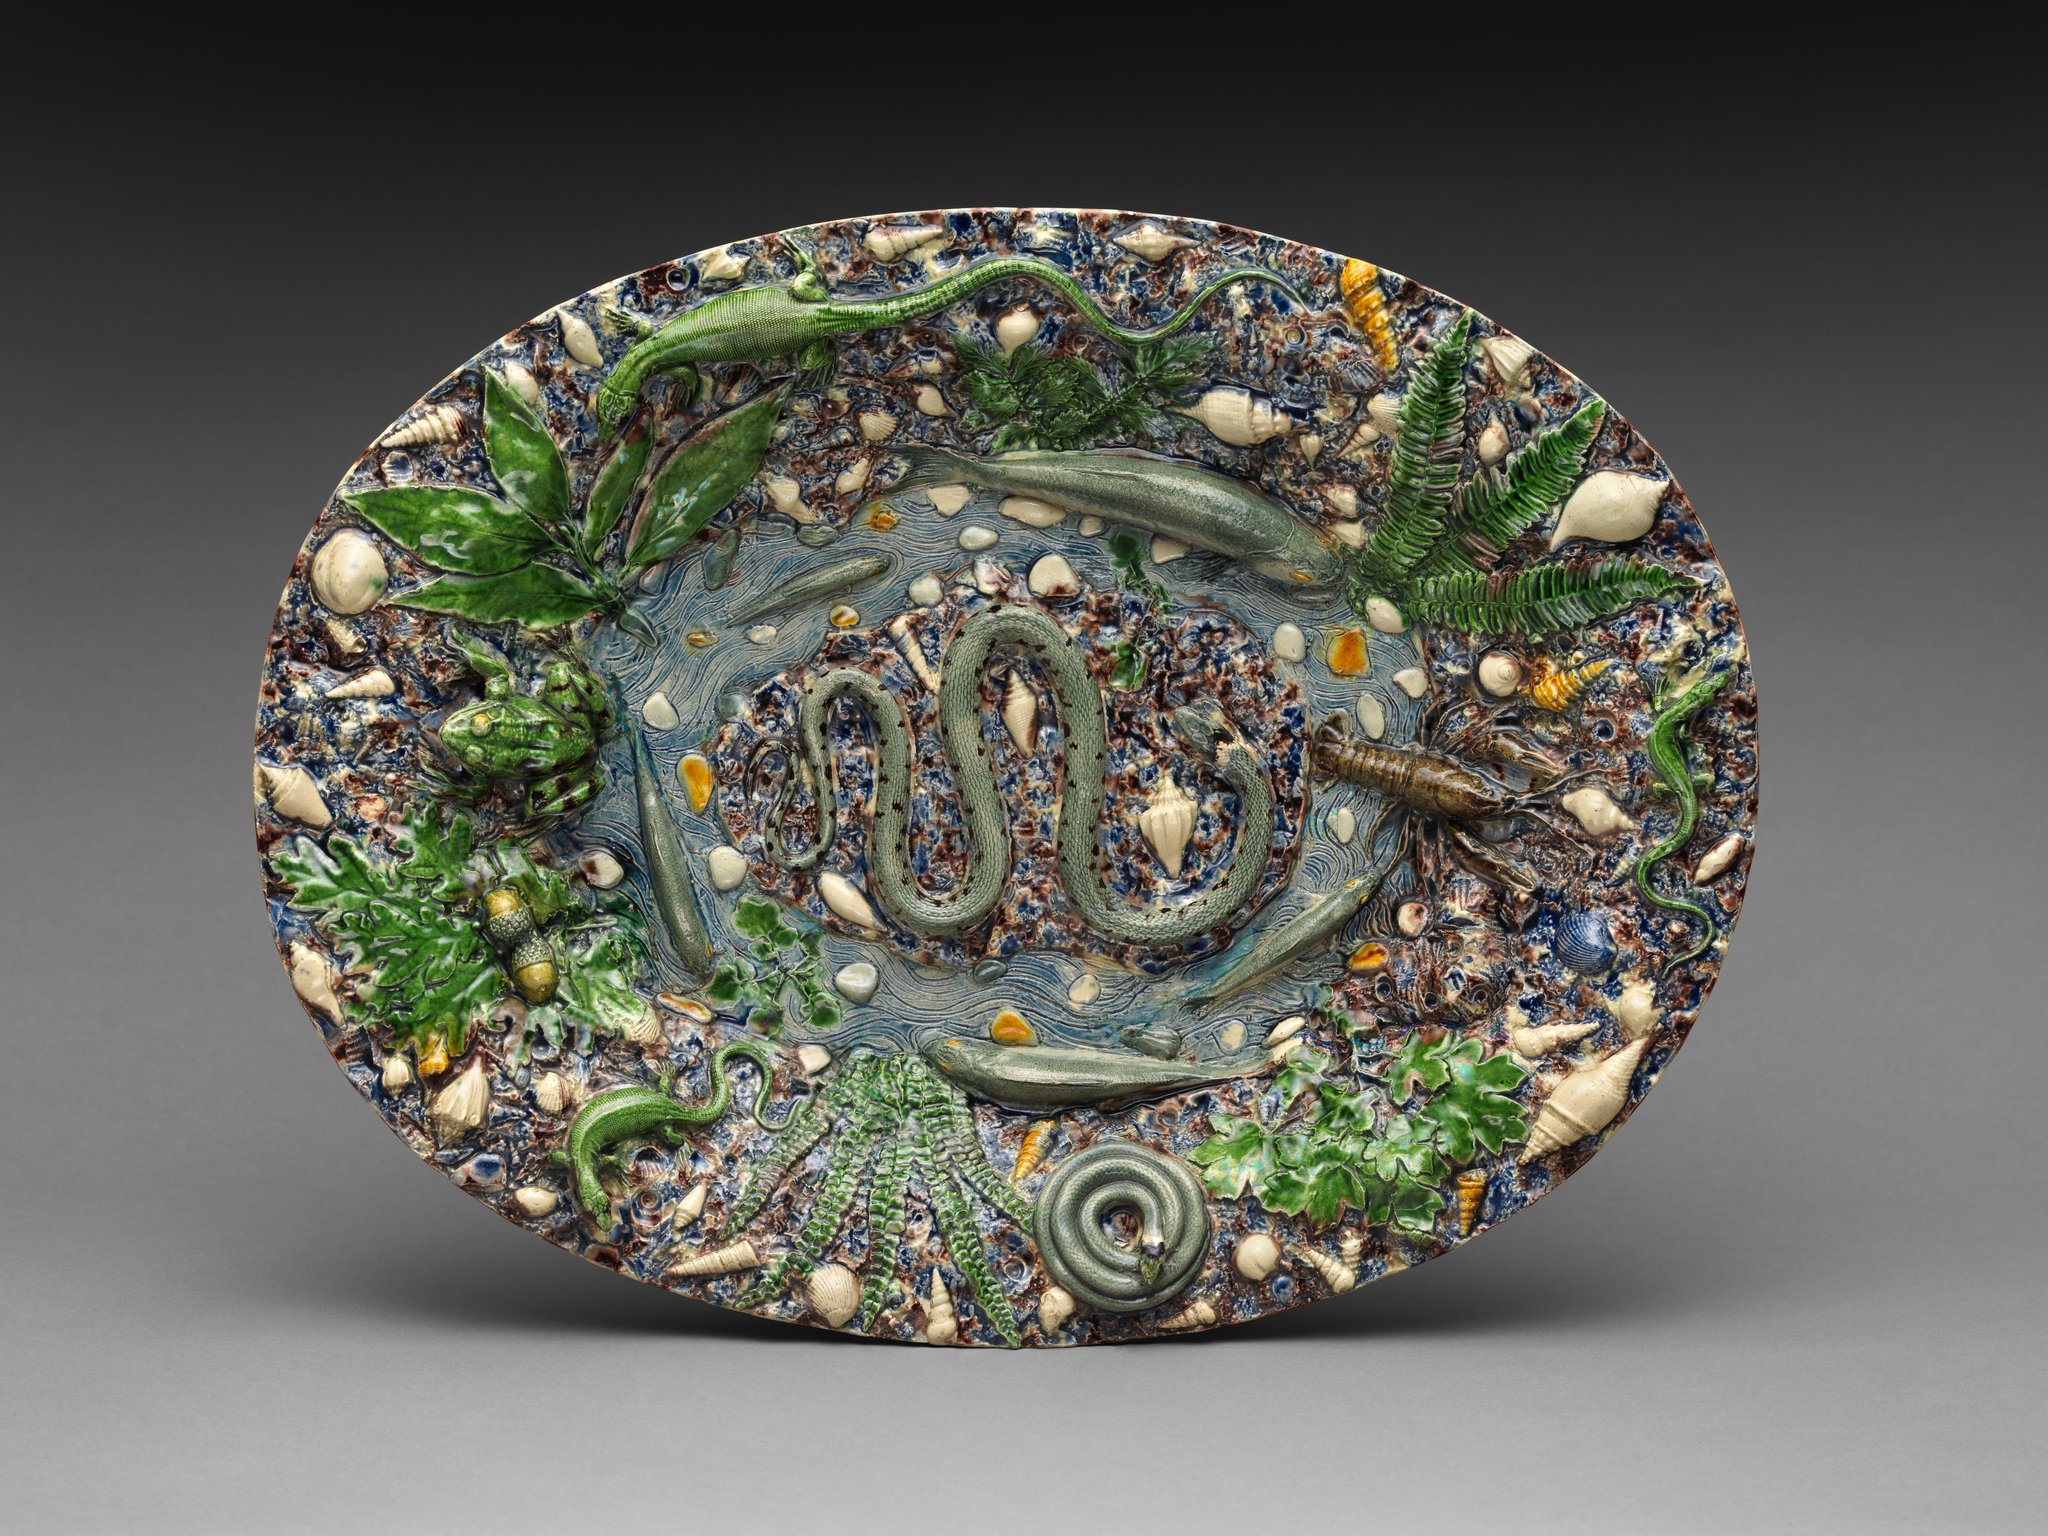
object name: platter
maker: bernard palissy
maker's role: maker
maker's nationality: french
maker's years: 1510-1590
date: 1576-1600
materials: earthenware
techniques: glazing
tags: fish,frogs,snakes,shells